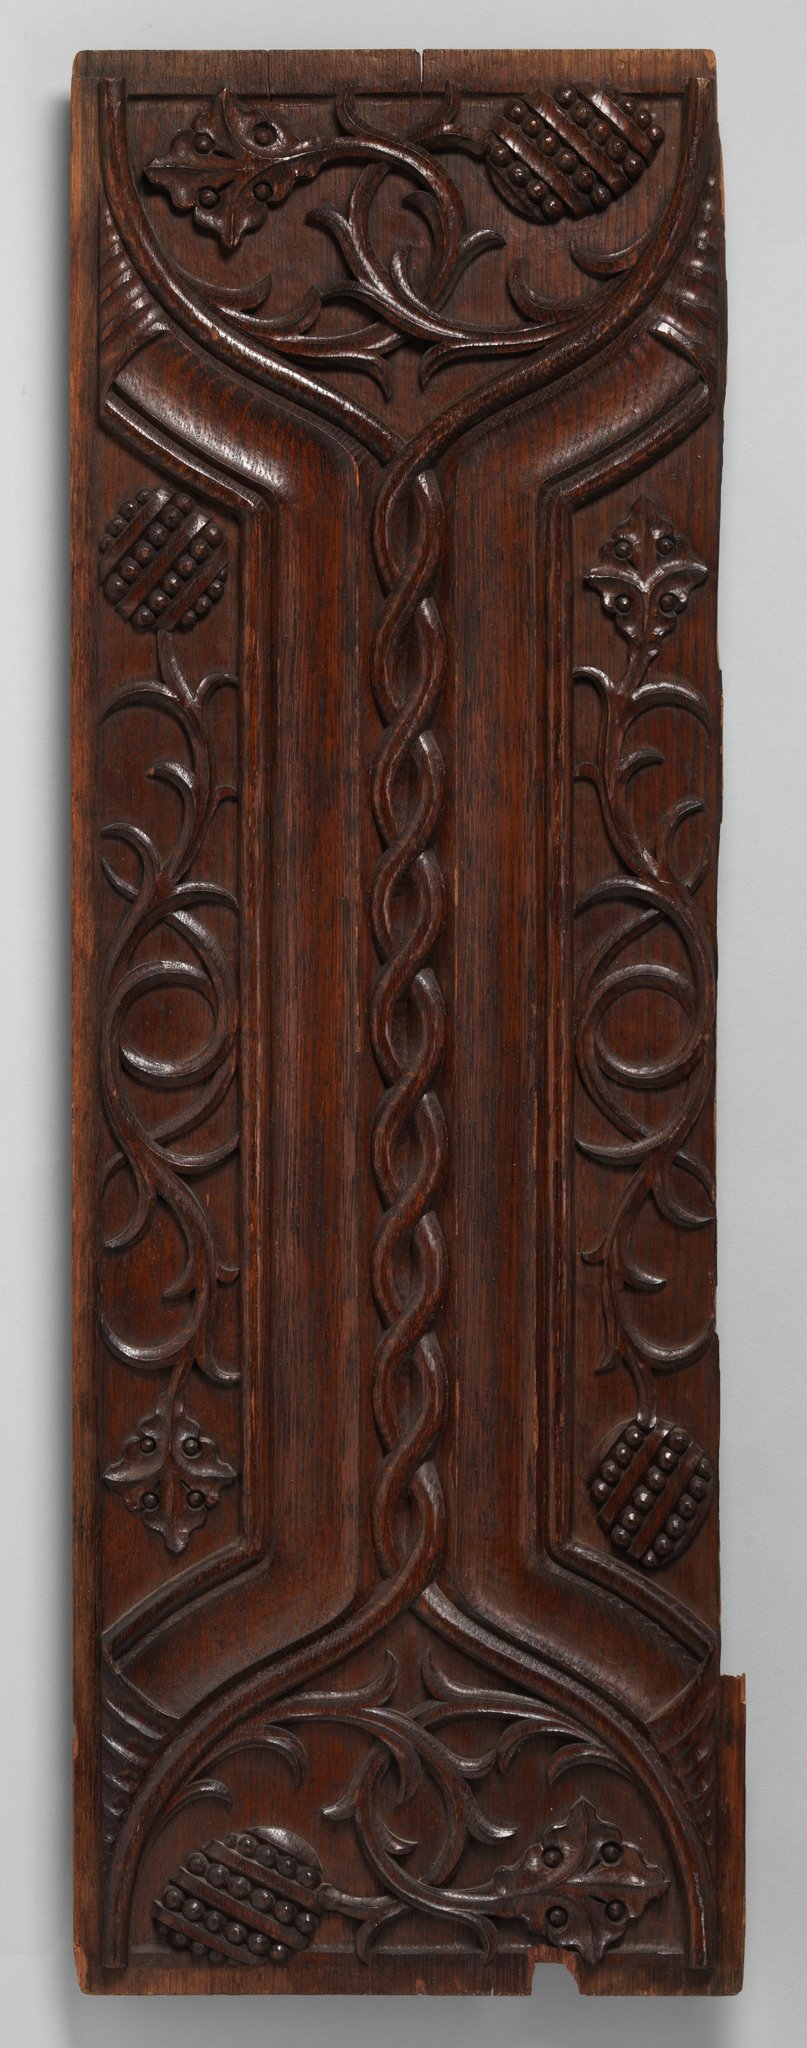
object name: panel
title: Decorative paneling from the Palace of Westminster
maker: augustus welby northmore pugin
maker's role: designer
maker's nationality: british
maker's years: 1812-1852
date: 1845-1859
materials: wood